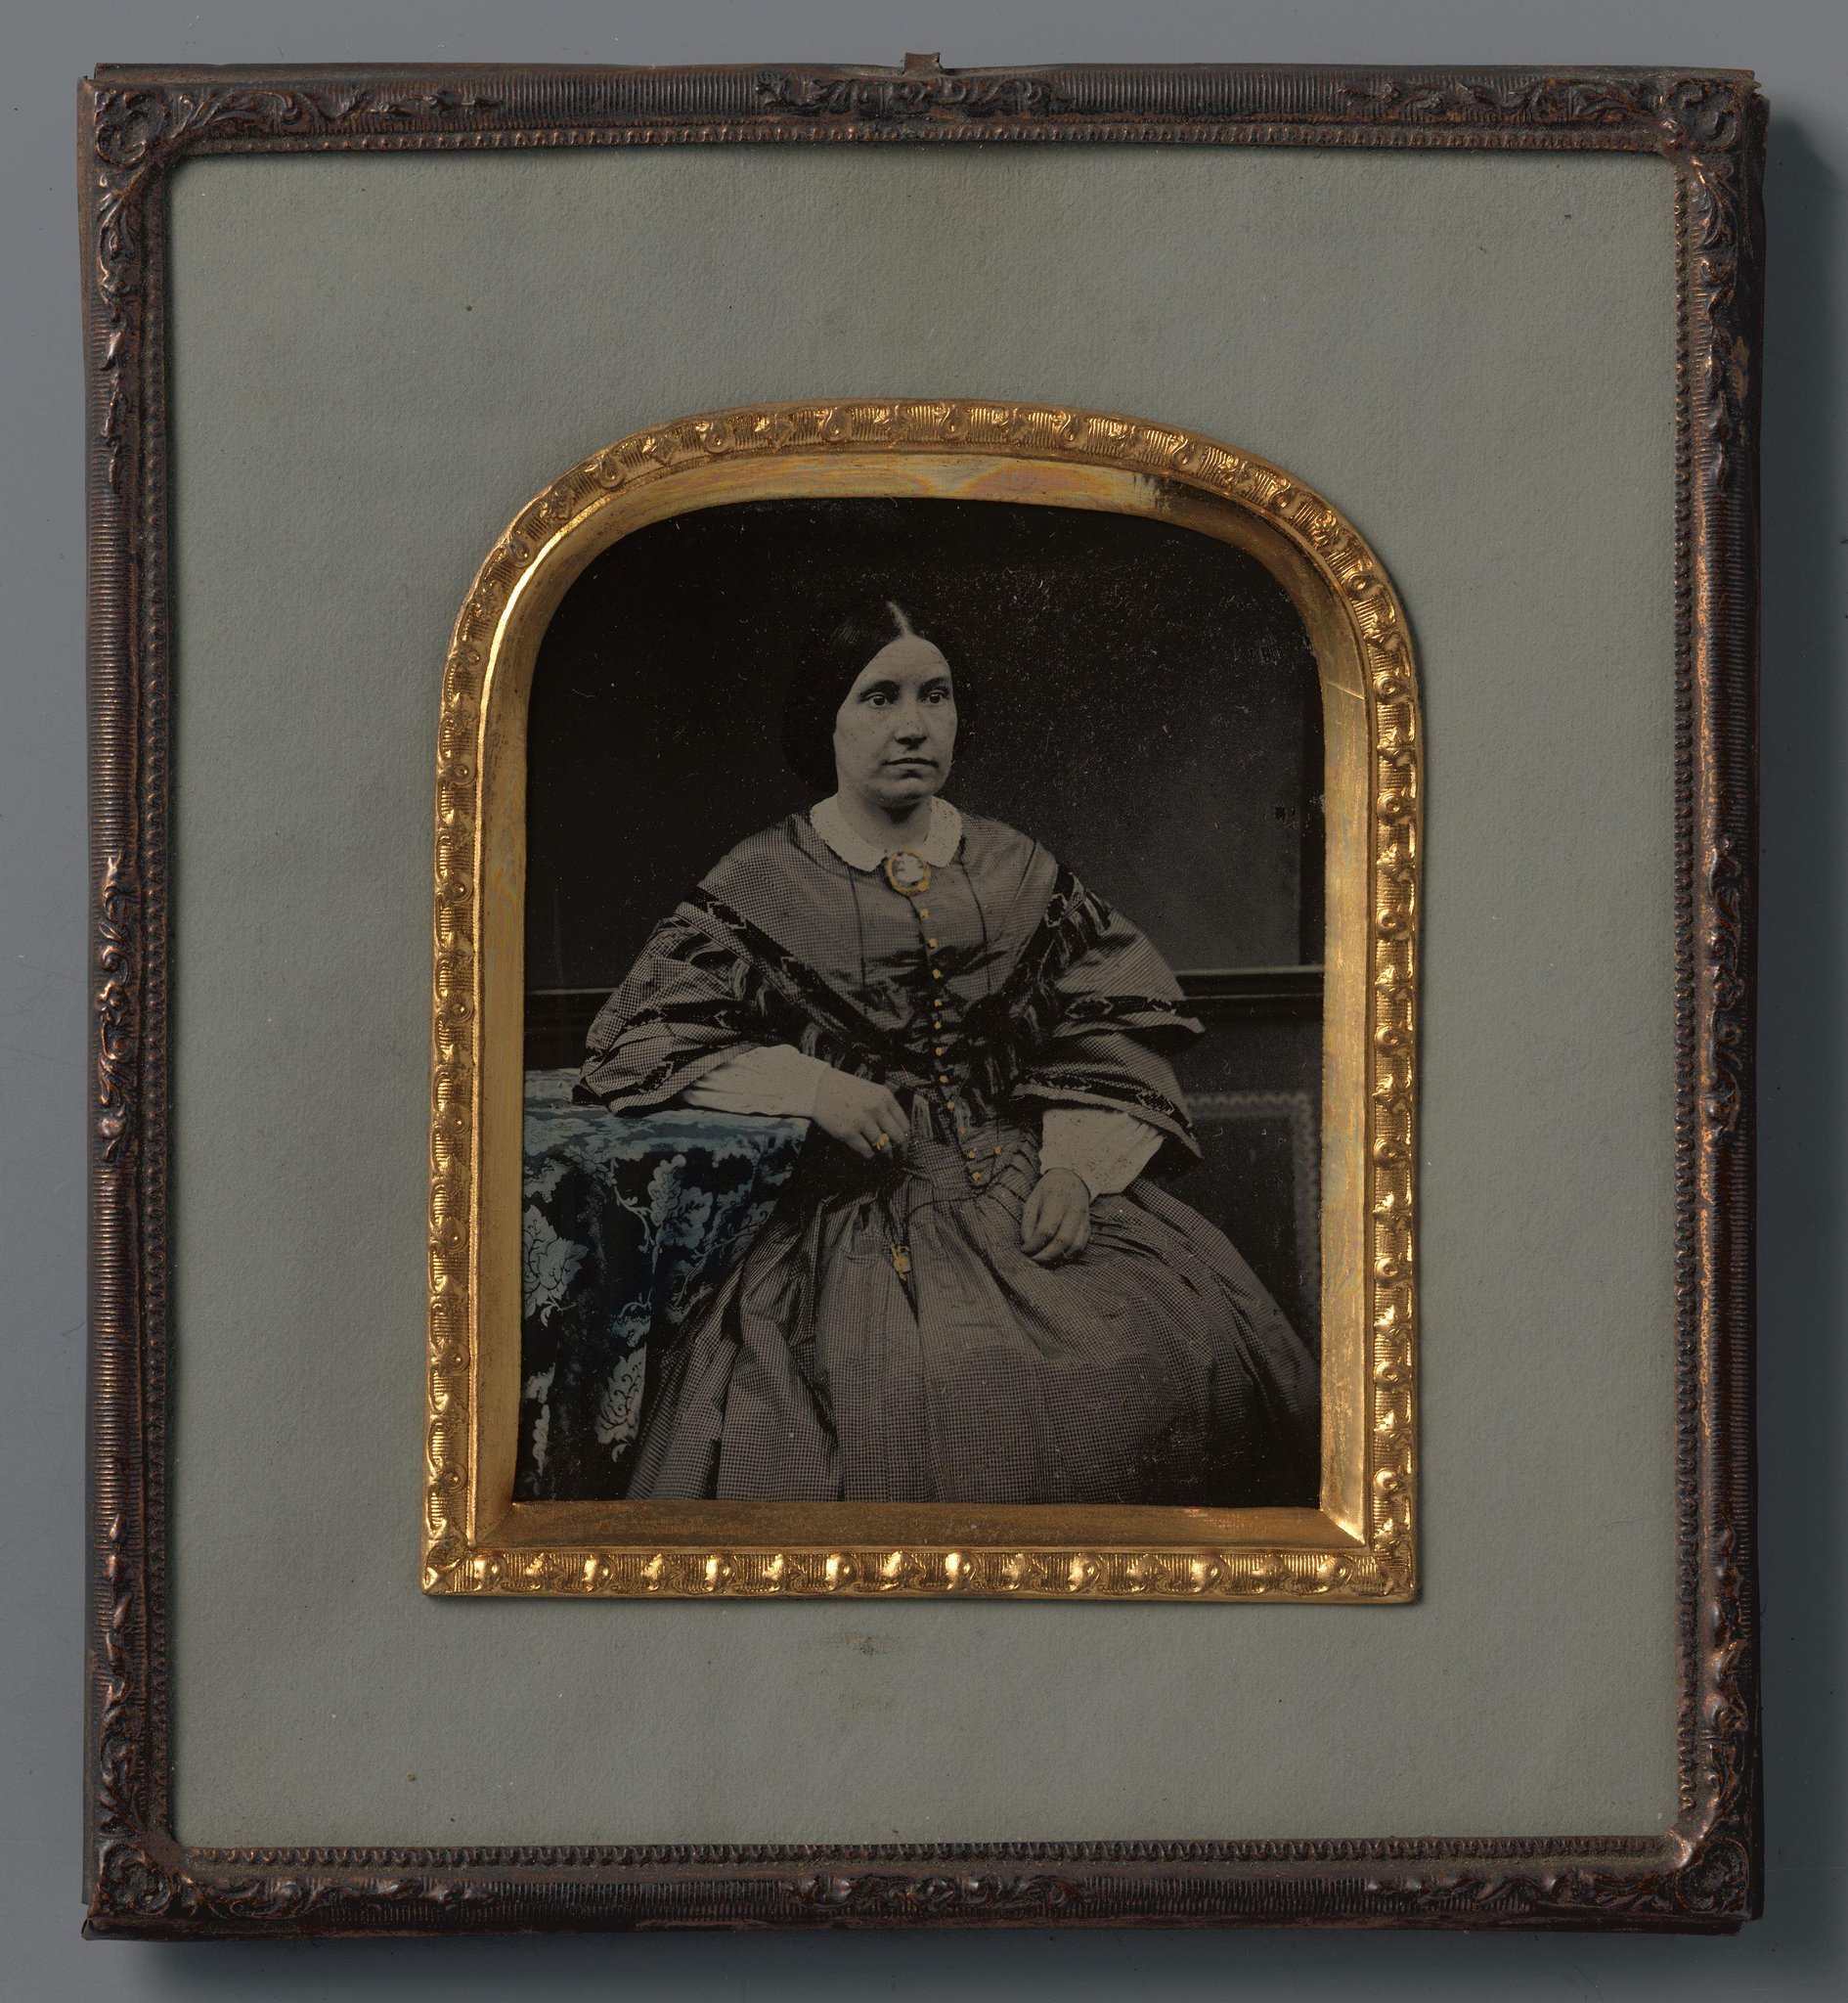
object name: photograph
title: Portret van een onbekende zittende vrouw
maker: william bath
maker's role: fotograaf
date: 1855-1870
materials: glass, metal, velvet, wood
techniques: ambrotype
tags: sitting figure - aa - female human figure, historical persons - bb - woman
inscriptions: inscription: ‘Aunt Erwina, grandmothers youngest sister’, inscription: ‘W. Bath's Portrait Rooms, 44 Farringdon Street Two doors from Holborn, E.C.’